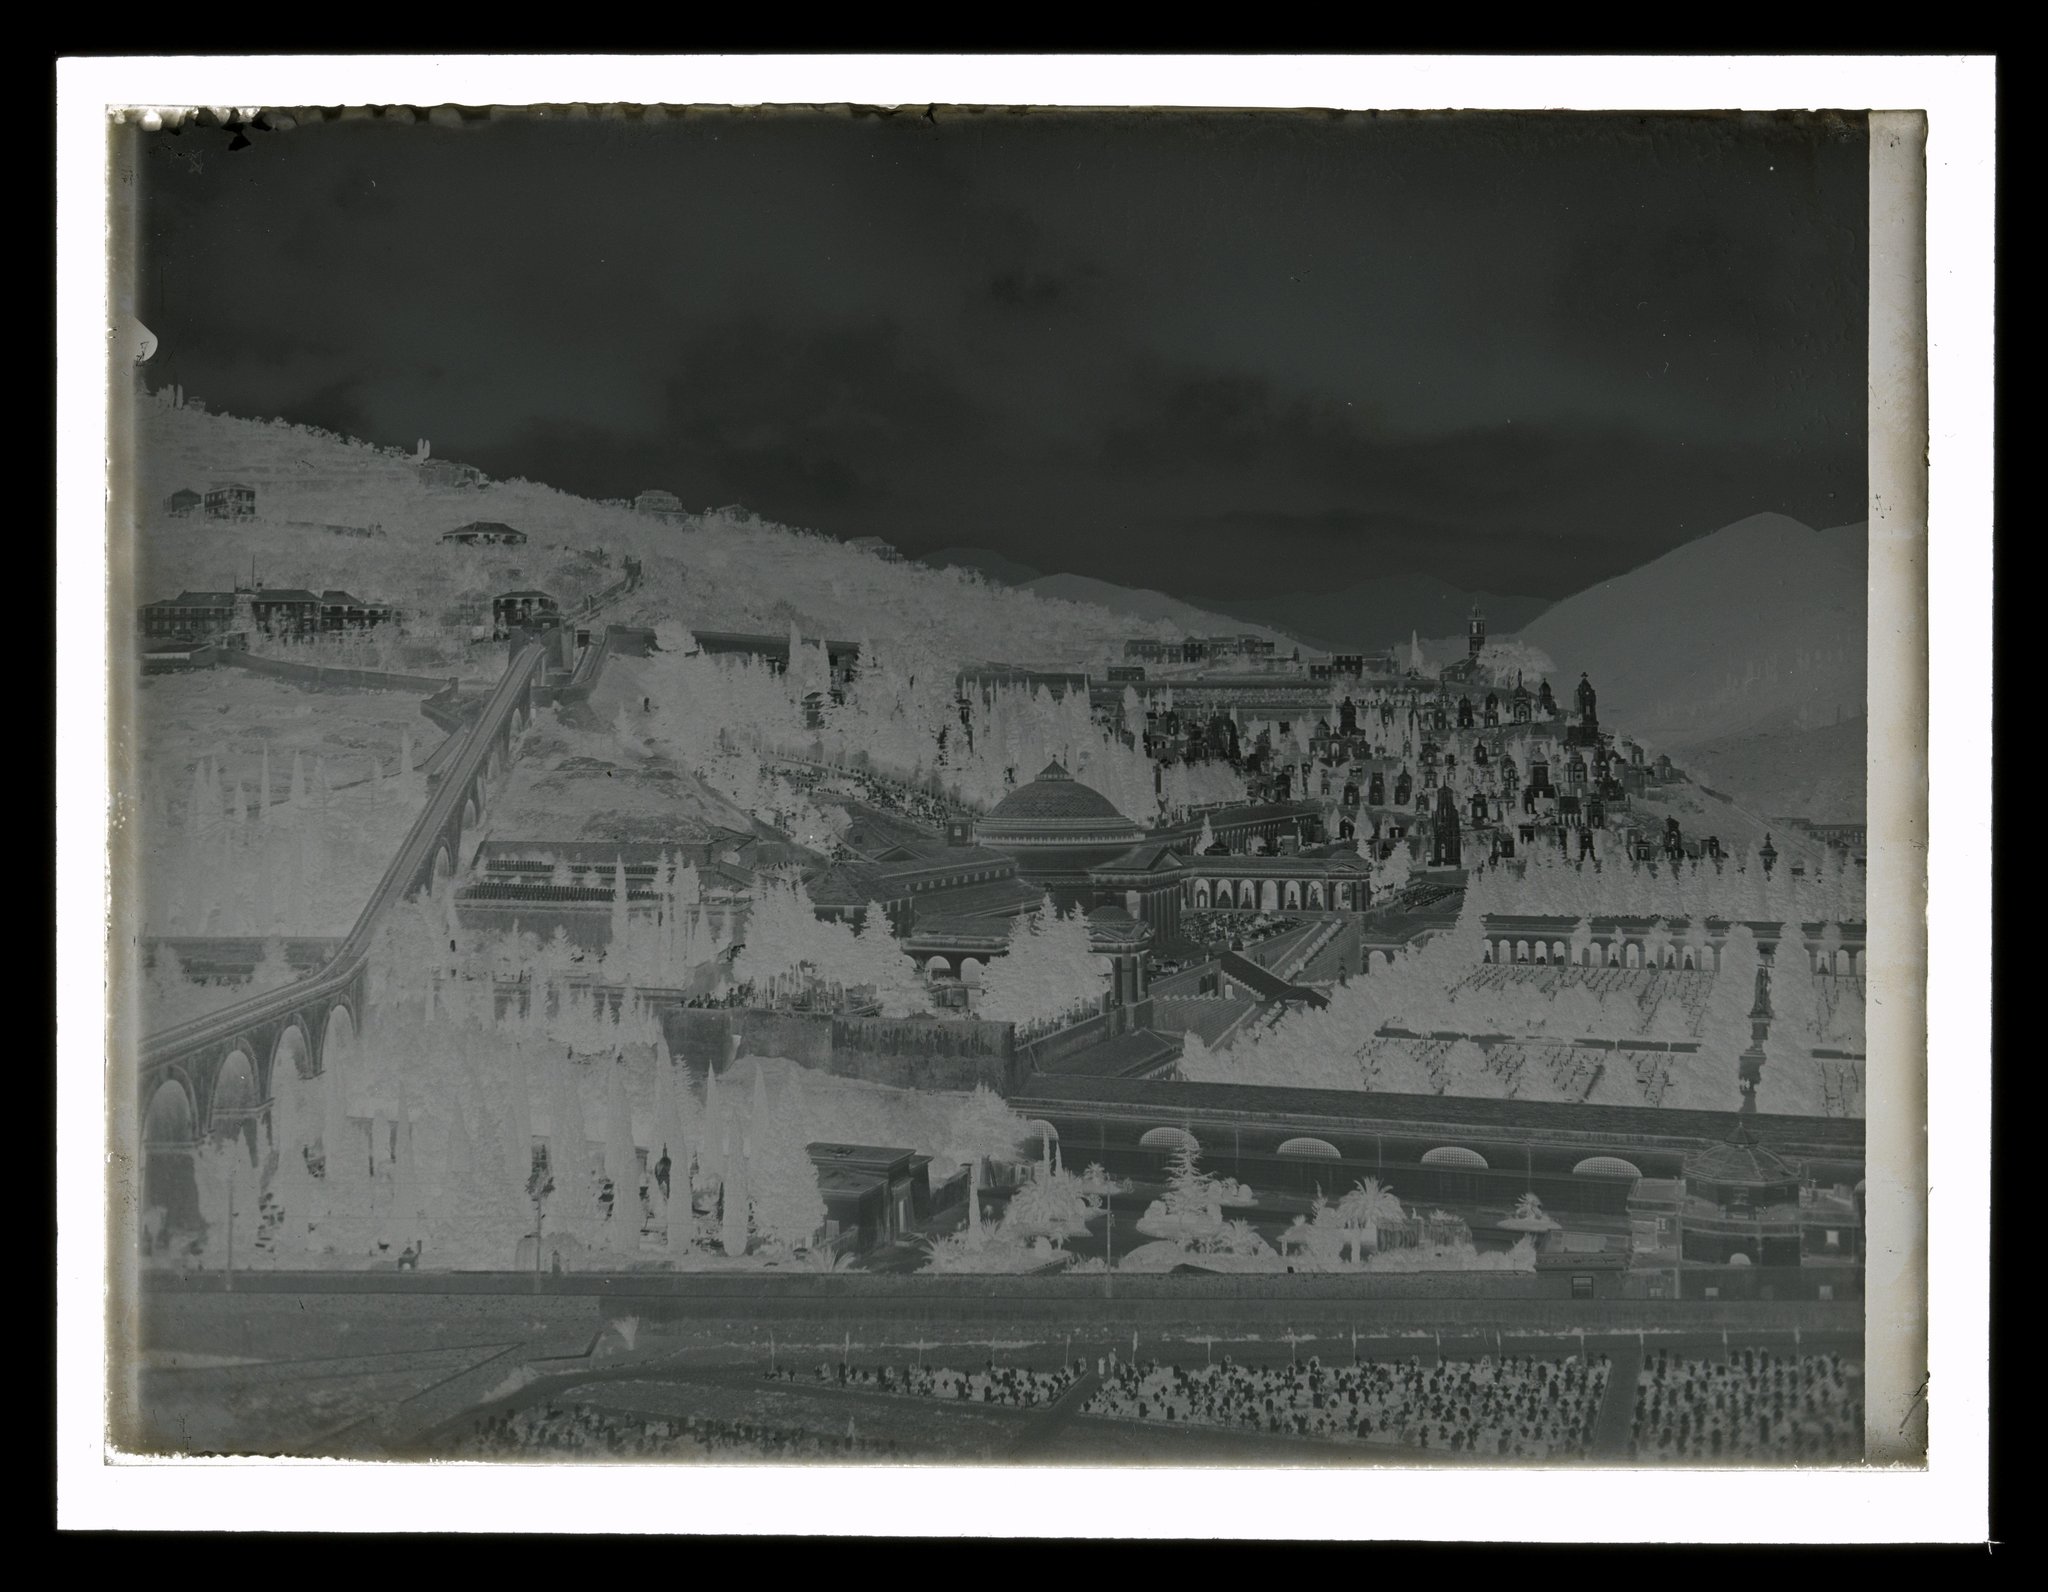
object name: photograph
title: Gezicht op de Monumentale Begraafplaats van Staglieno, Genua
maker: Anonymous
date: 1907-1935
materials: glass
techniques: gelatin glass negative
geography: genoa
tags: churchyard, cemetery